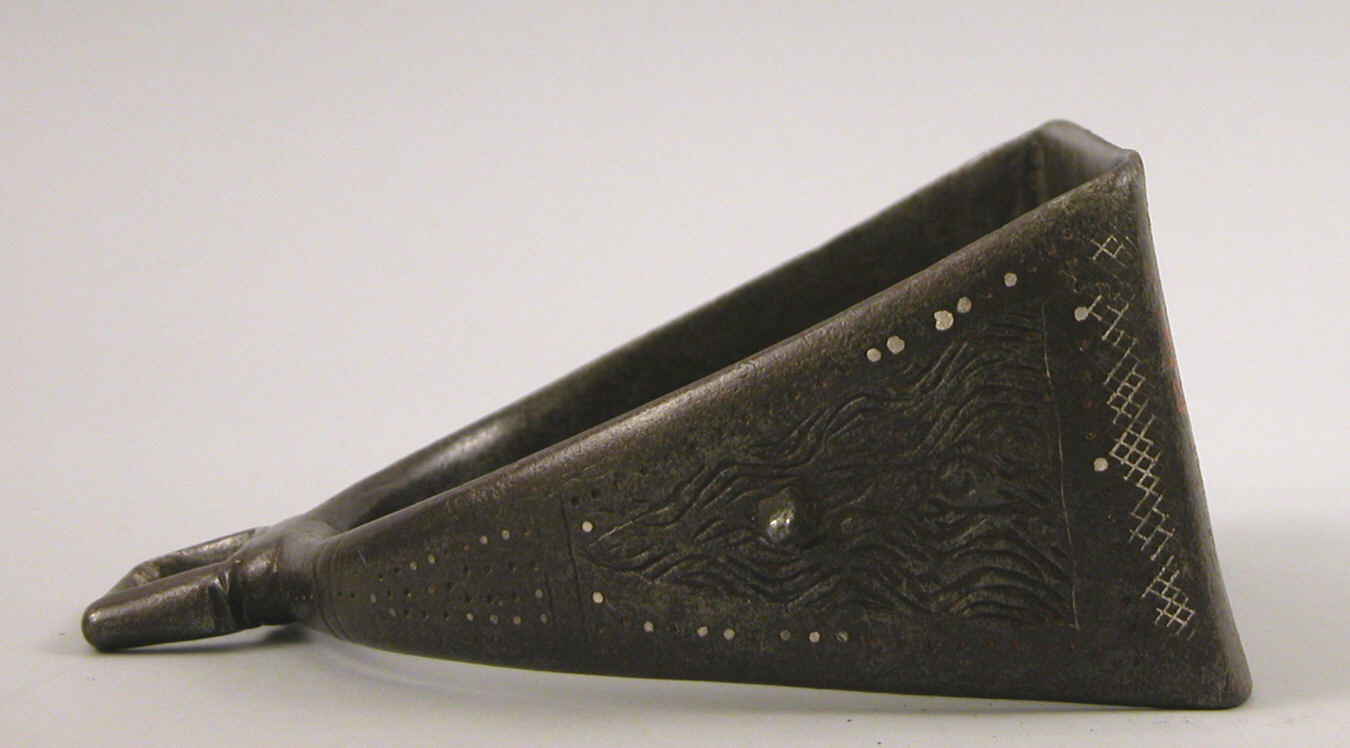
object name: stirrup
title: Stirrups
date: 1401-1500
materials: iron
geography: egypt